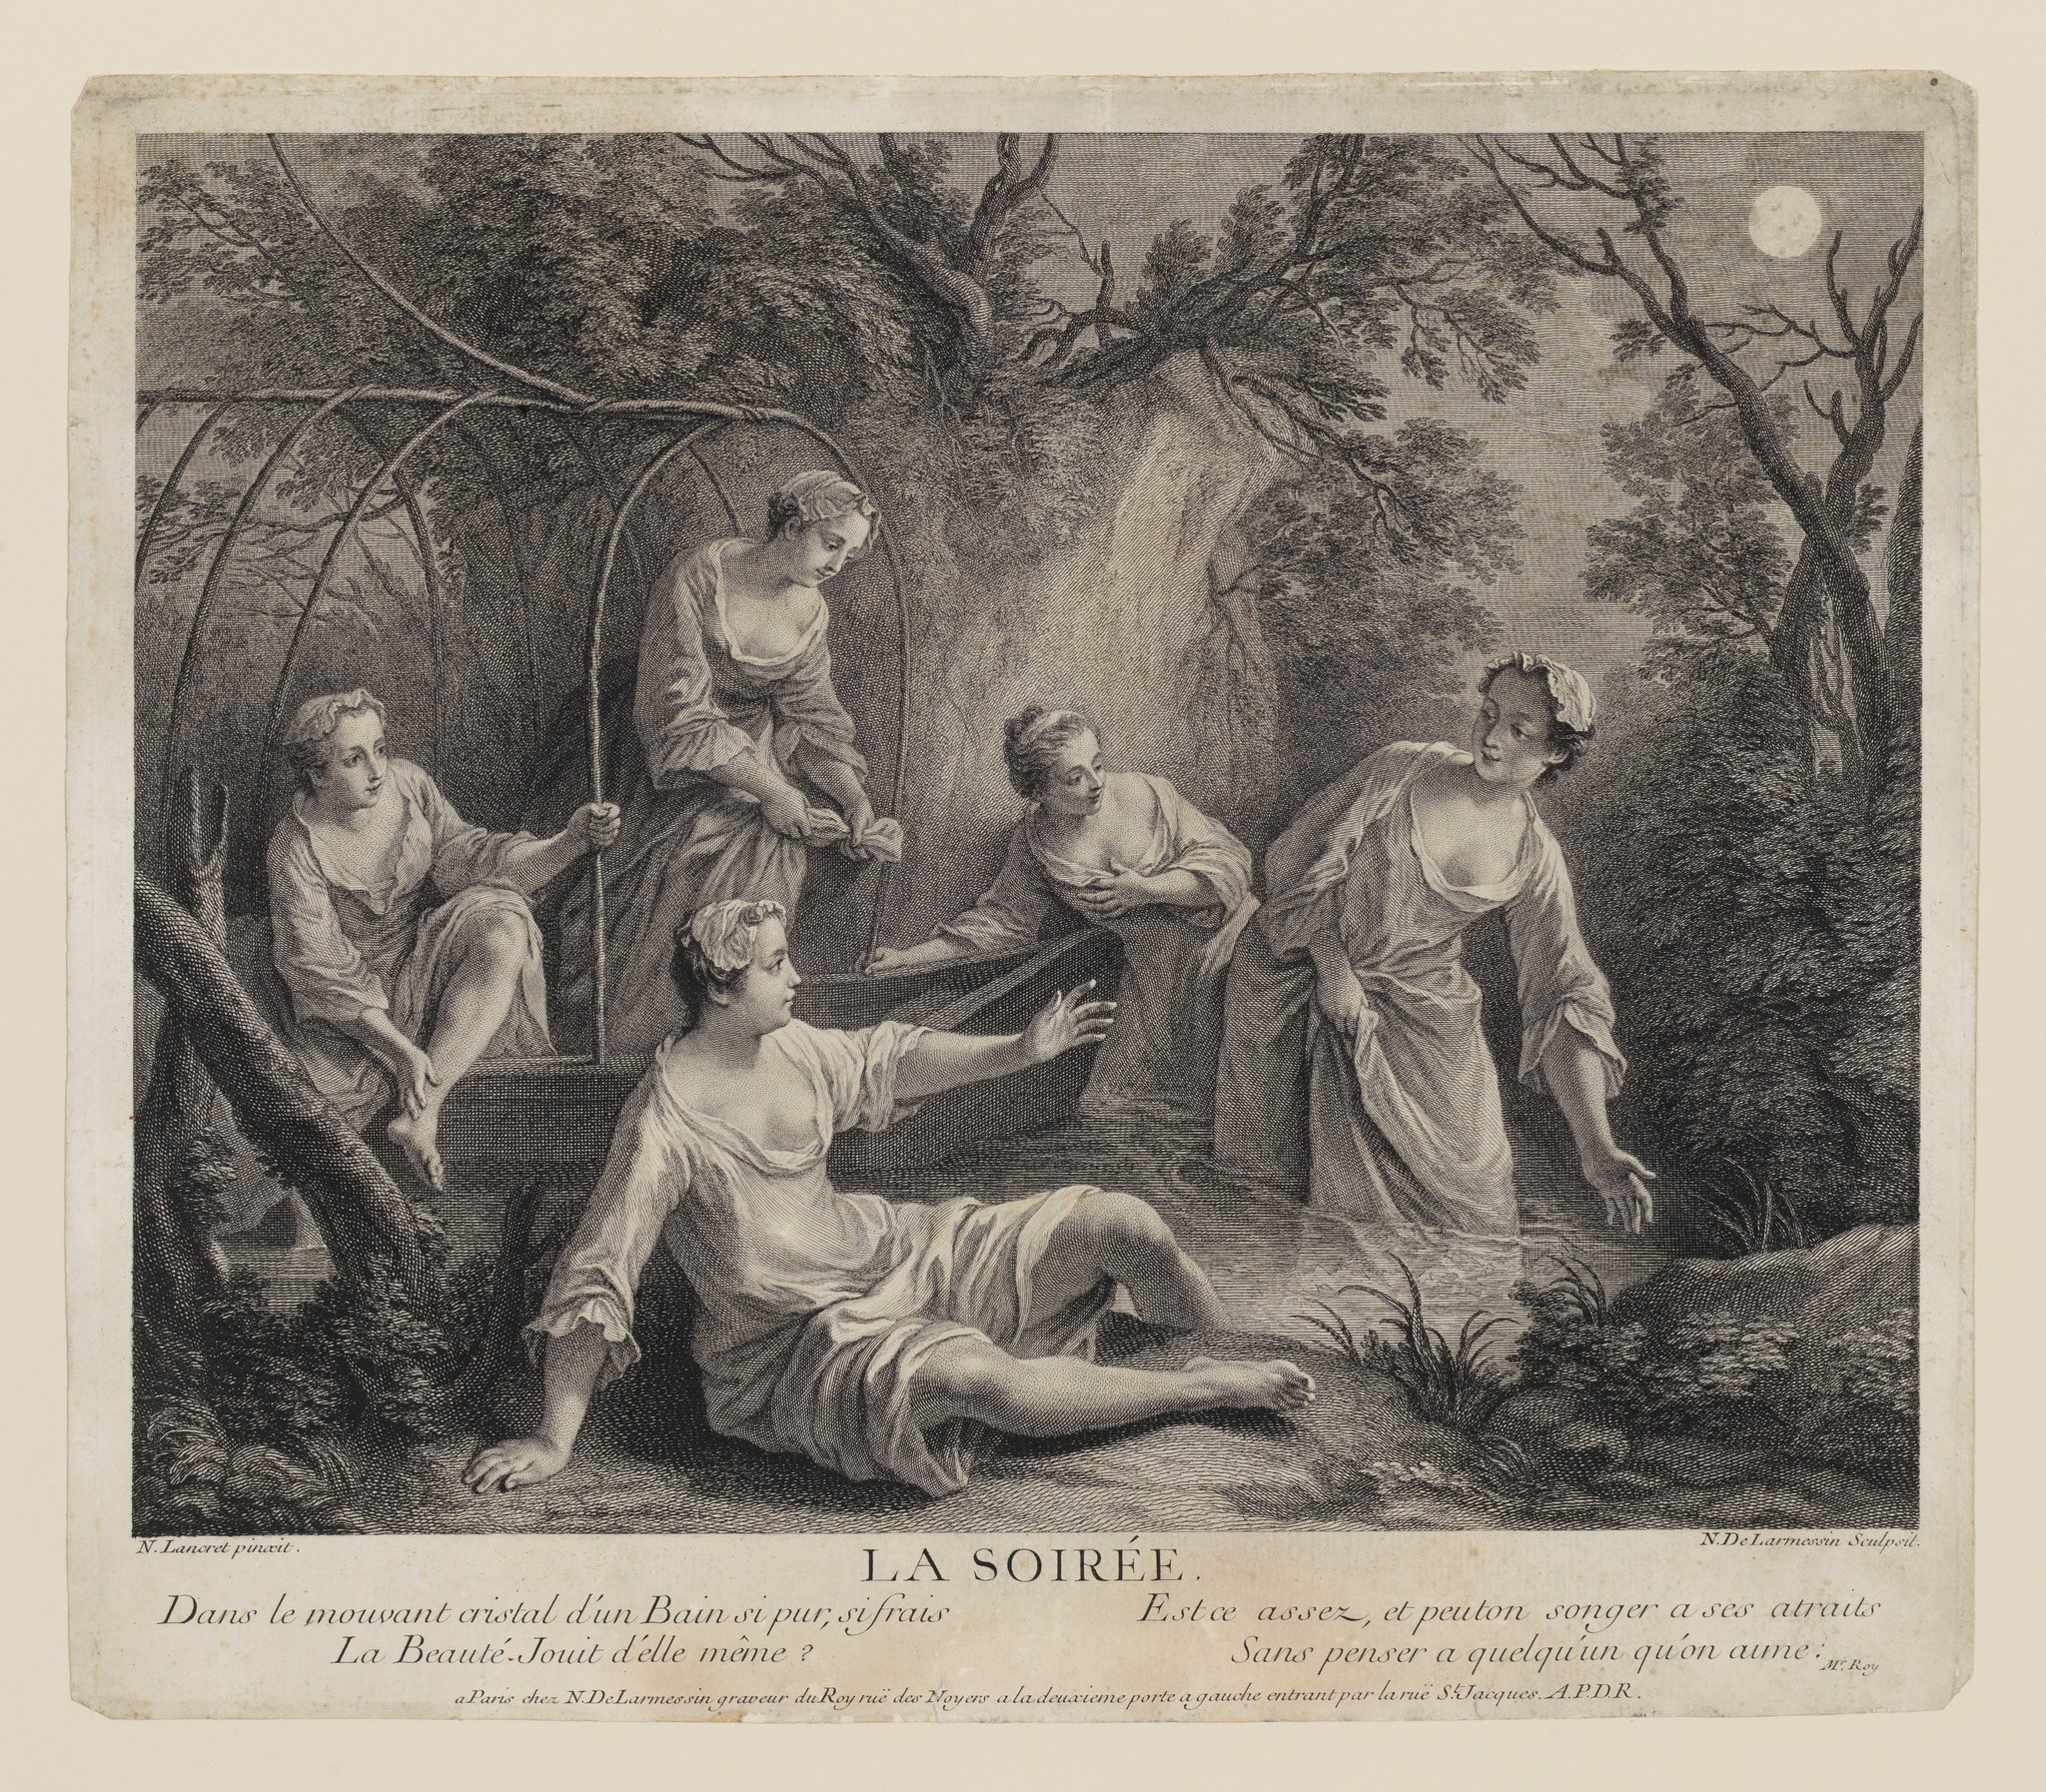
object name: print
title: Evening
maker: nicolas de larmessin iii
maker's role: engraver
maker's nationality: french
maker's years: 1685-1755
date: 1741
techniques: engraving, etching